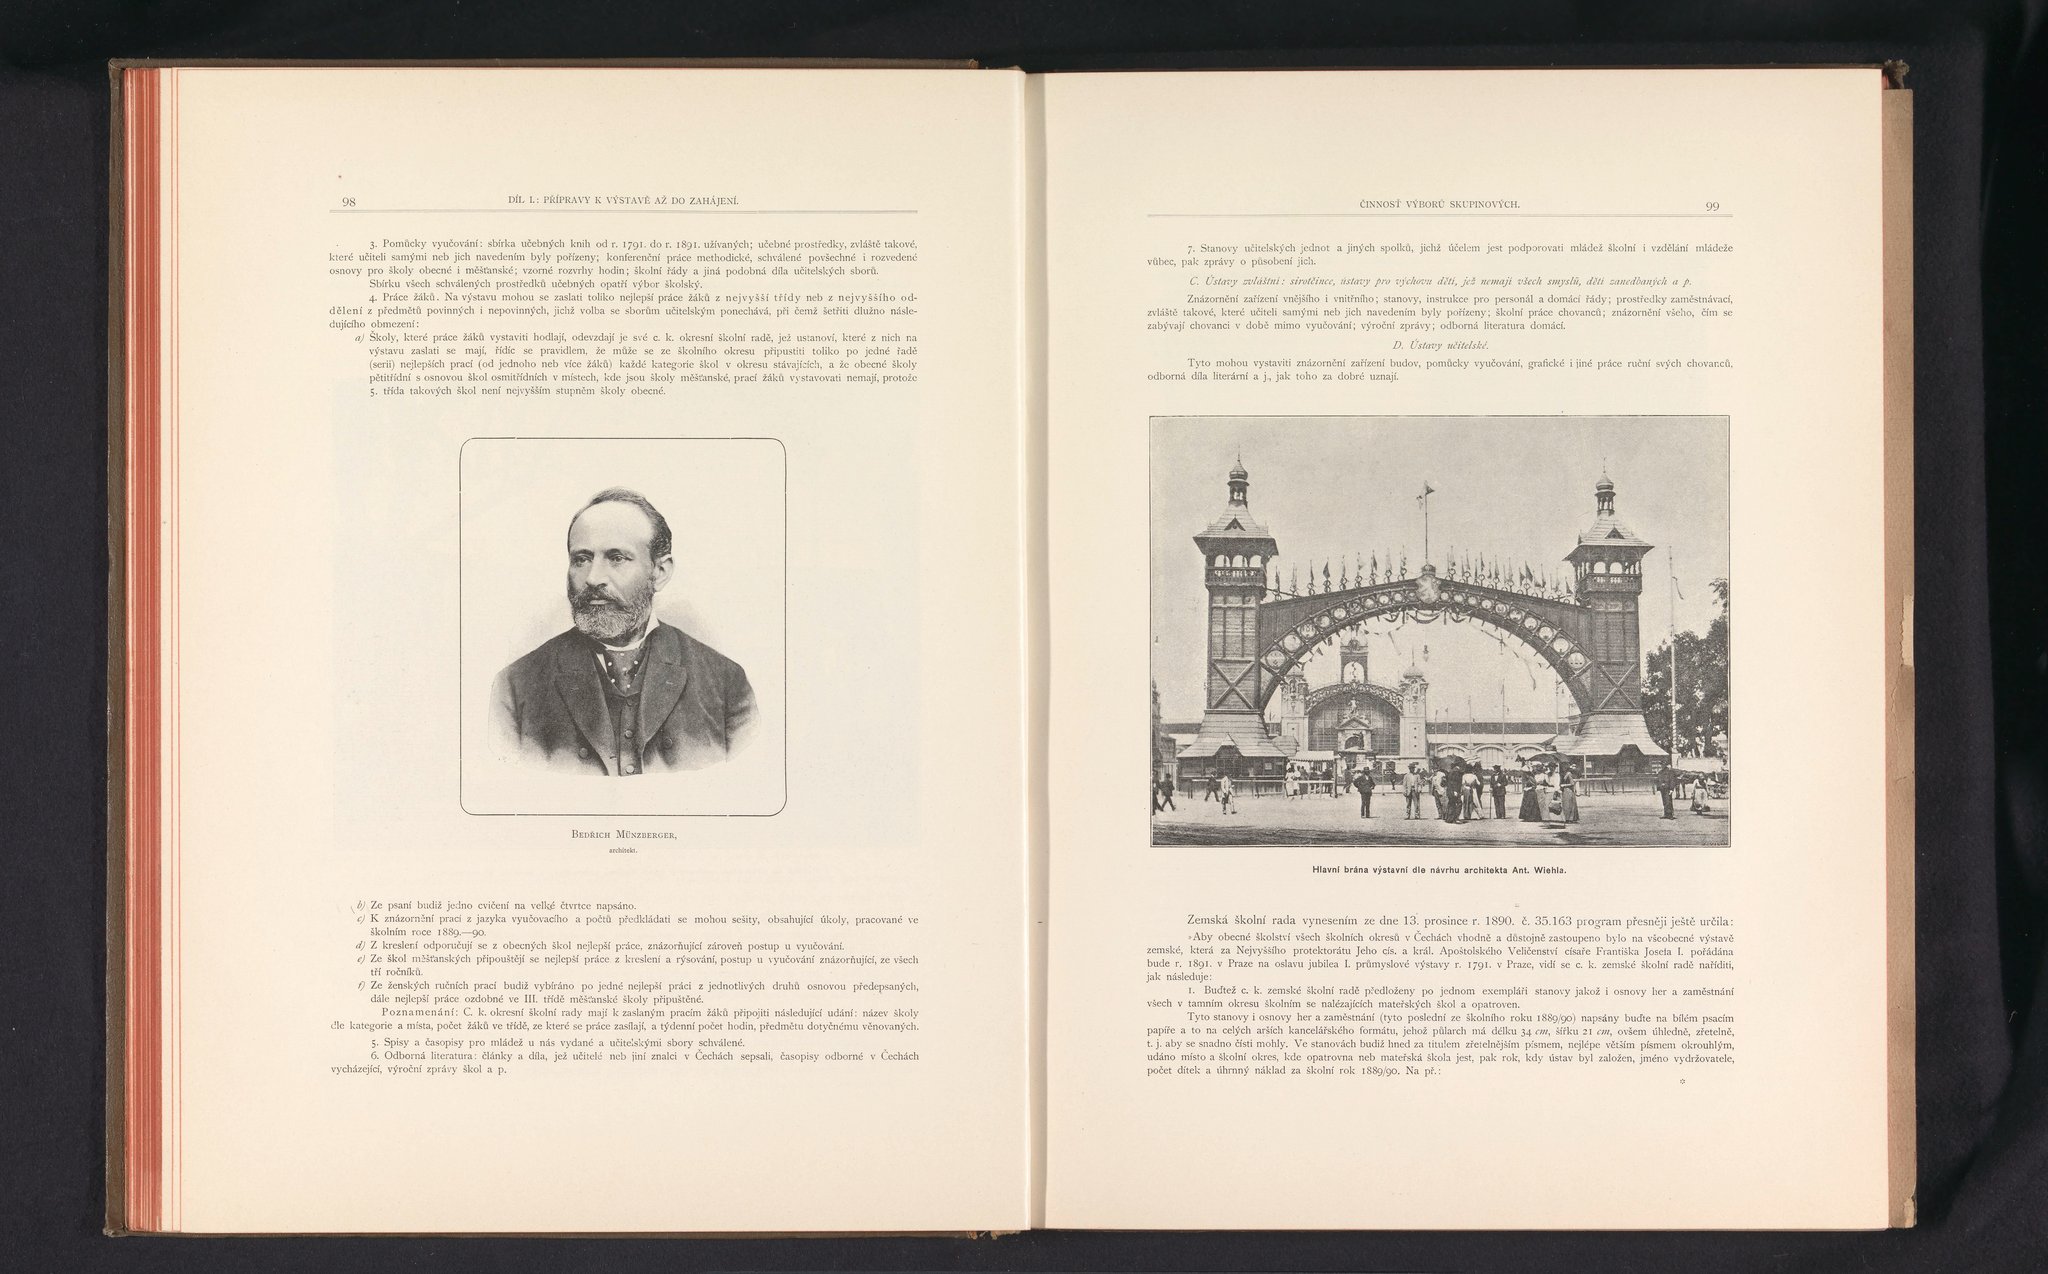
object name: page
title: Portret van Bedřich Münzberger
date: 1888-1893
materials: paper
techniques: autotype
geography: prague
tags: portrait, self-portrait of architect